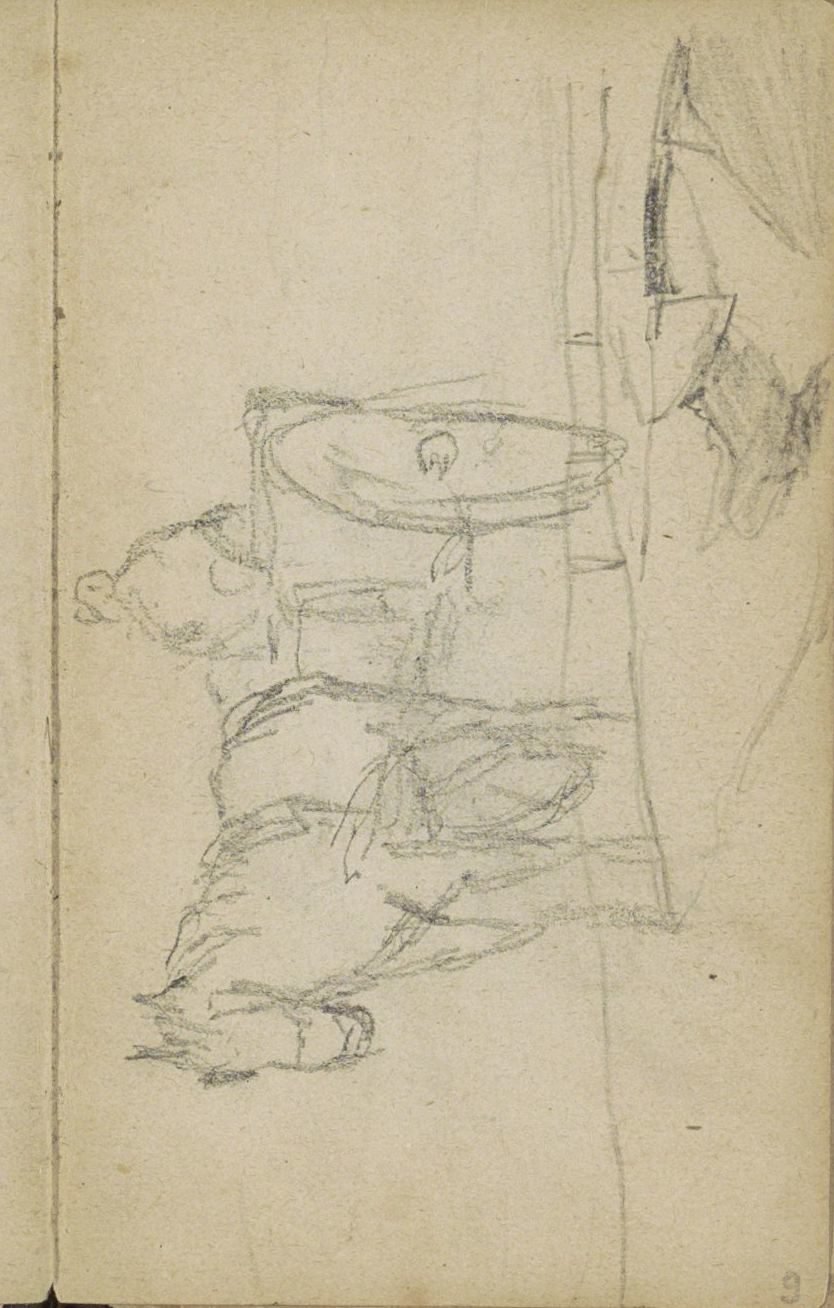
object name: sketchbook leaf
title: Figuur op een paardenkar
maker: johan hendrik weissenbruch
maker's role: draughtsman, painter, print maker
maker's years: 1824-1903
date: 1834-1903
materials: paper, pencil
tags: two-wheeled, animal-drawn vehicle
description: Blad 9 recto uit een schetsboek met 32 bladen.